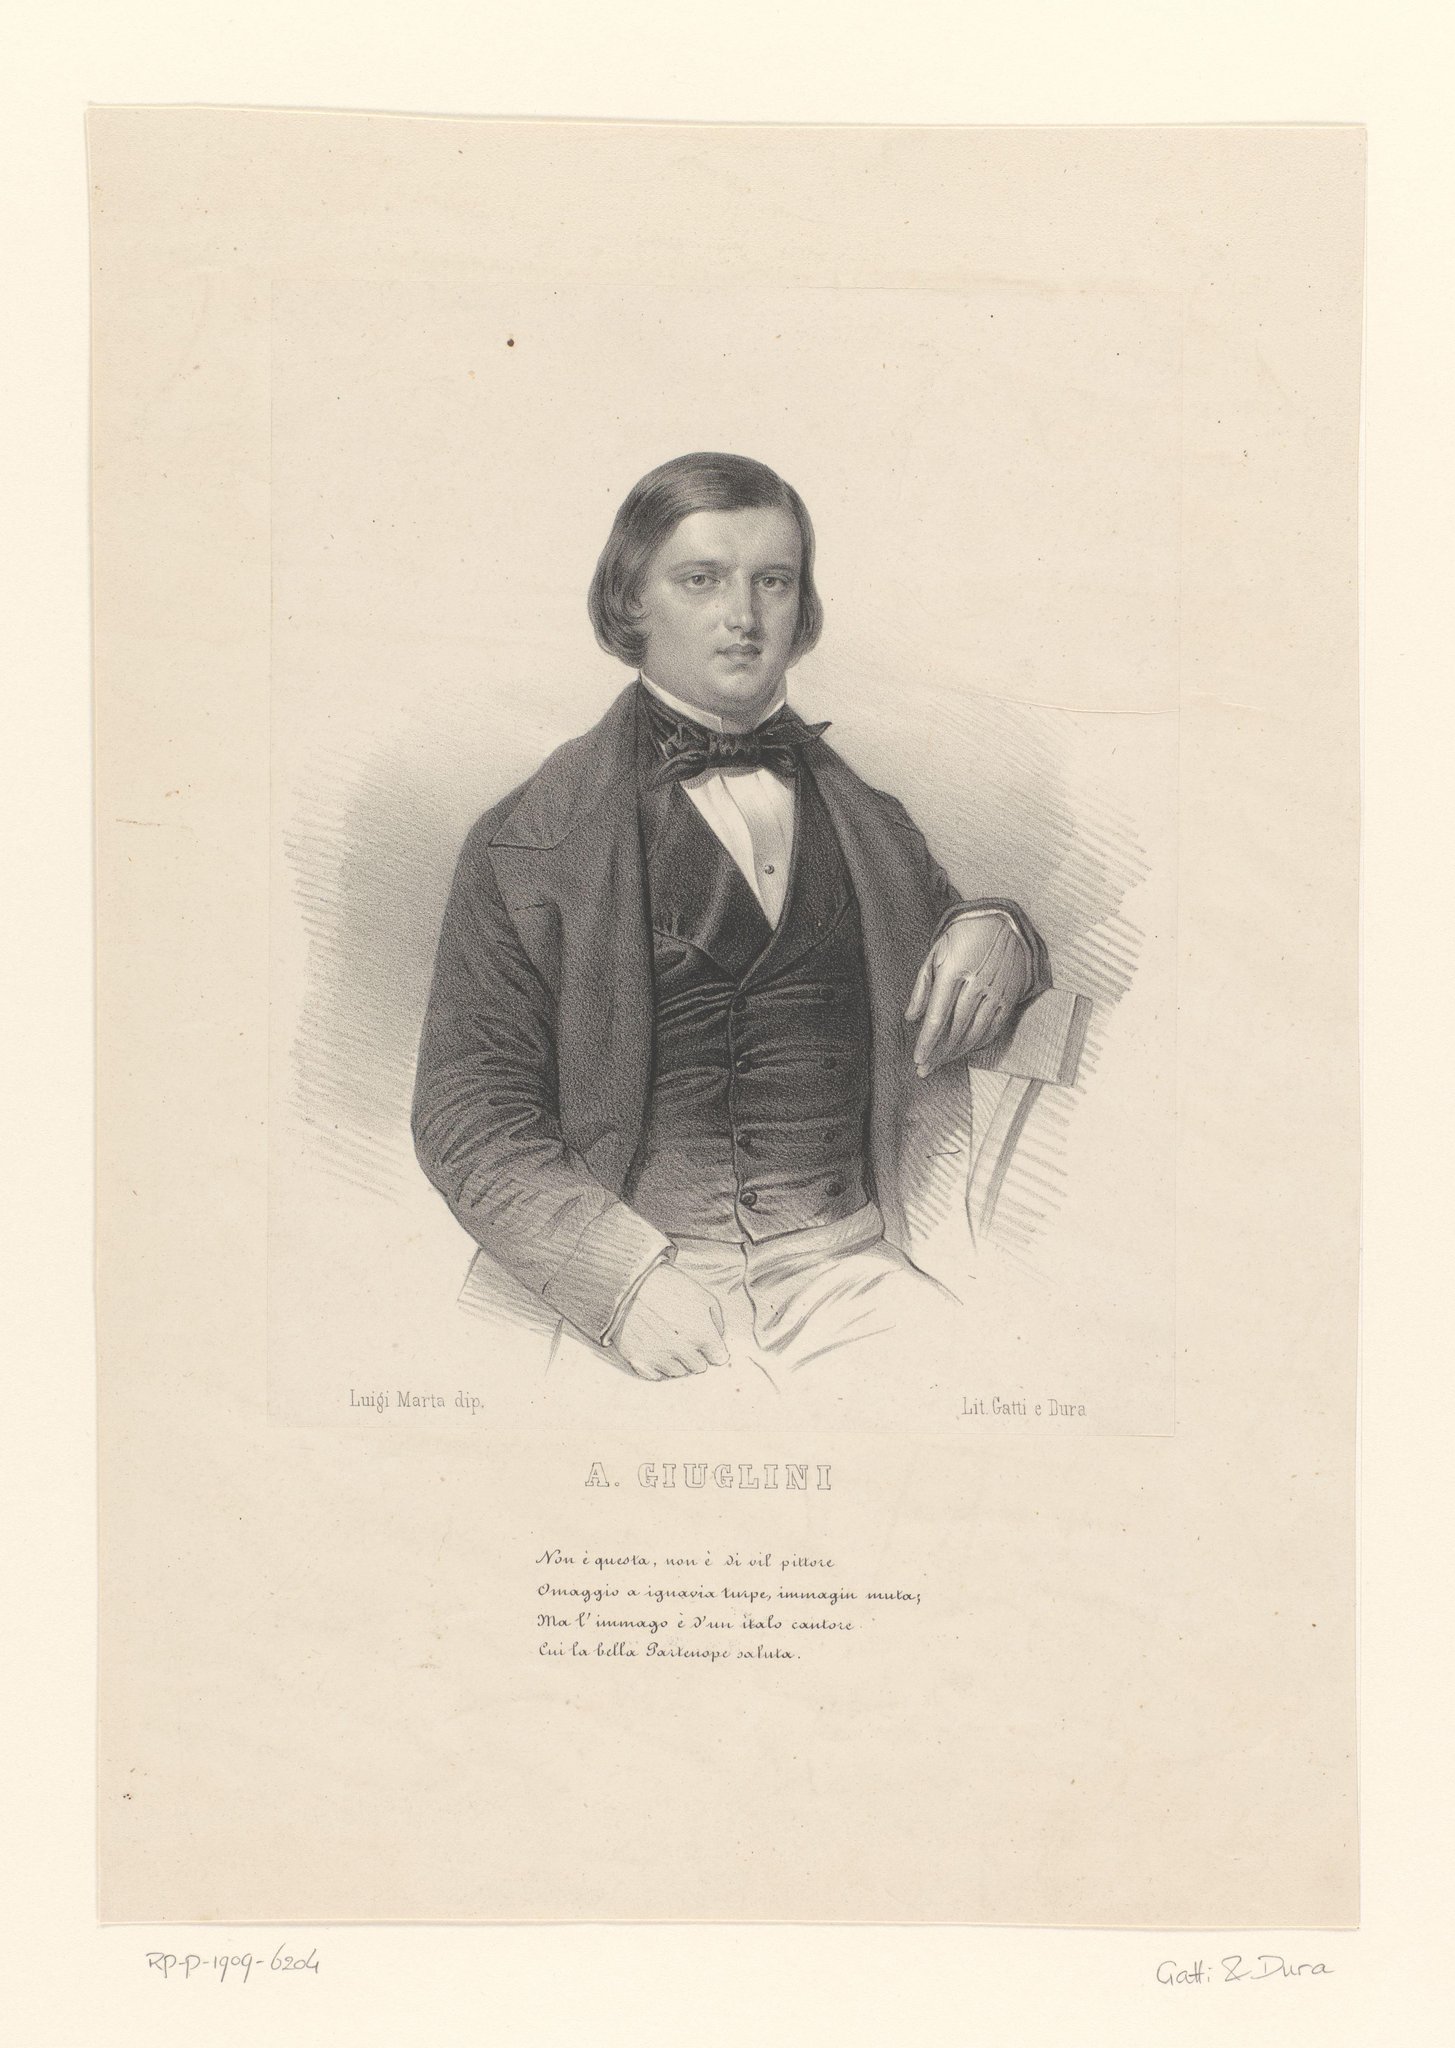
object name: print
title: Portret van operazanger Antonio Giuglini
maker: luigi marta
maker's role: miniatuurschilder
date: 1800-1899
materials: paper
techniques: lithograph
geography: italy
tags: historical persons, opera-singer (male)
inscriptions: collector's mark: Lugt 2228